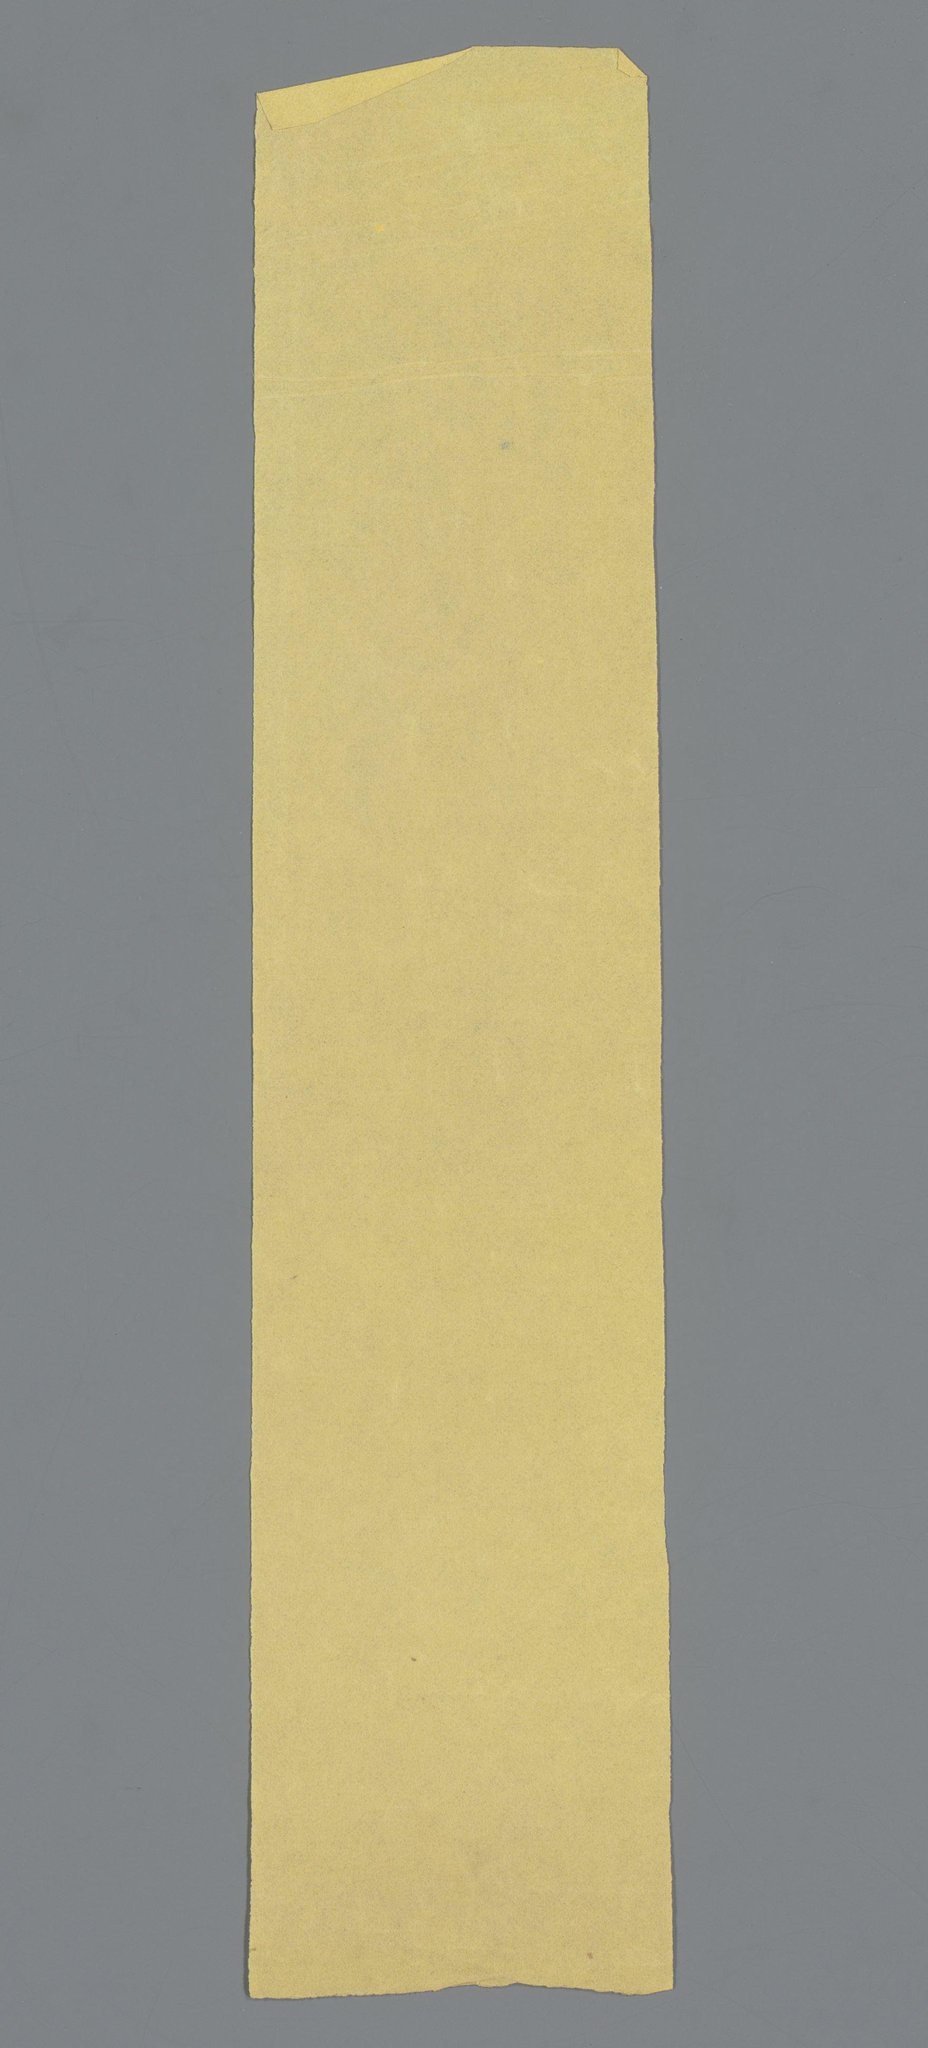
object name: decorated paper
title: Effen geel papier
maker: Anonymous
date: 1800-1900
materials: paint, paper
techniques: painting